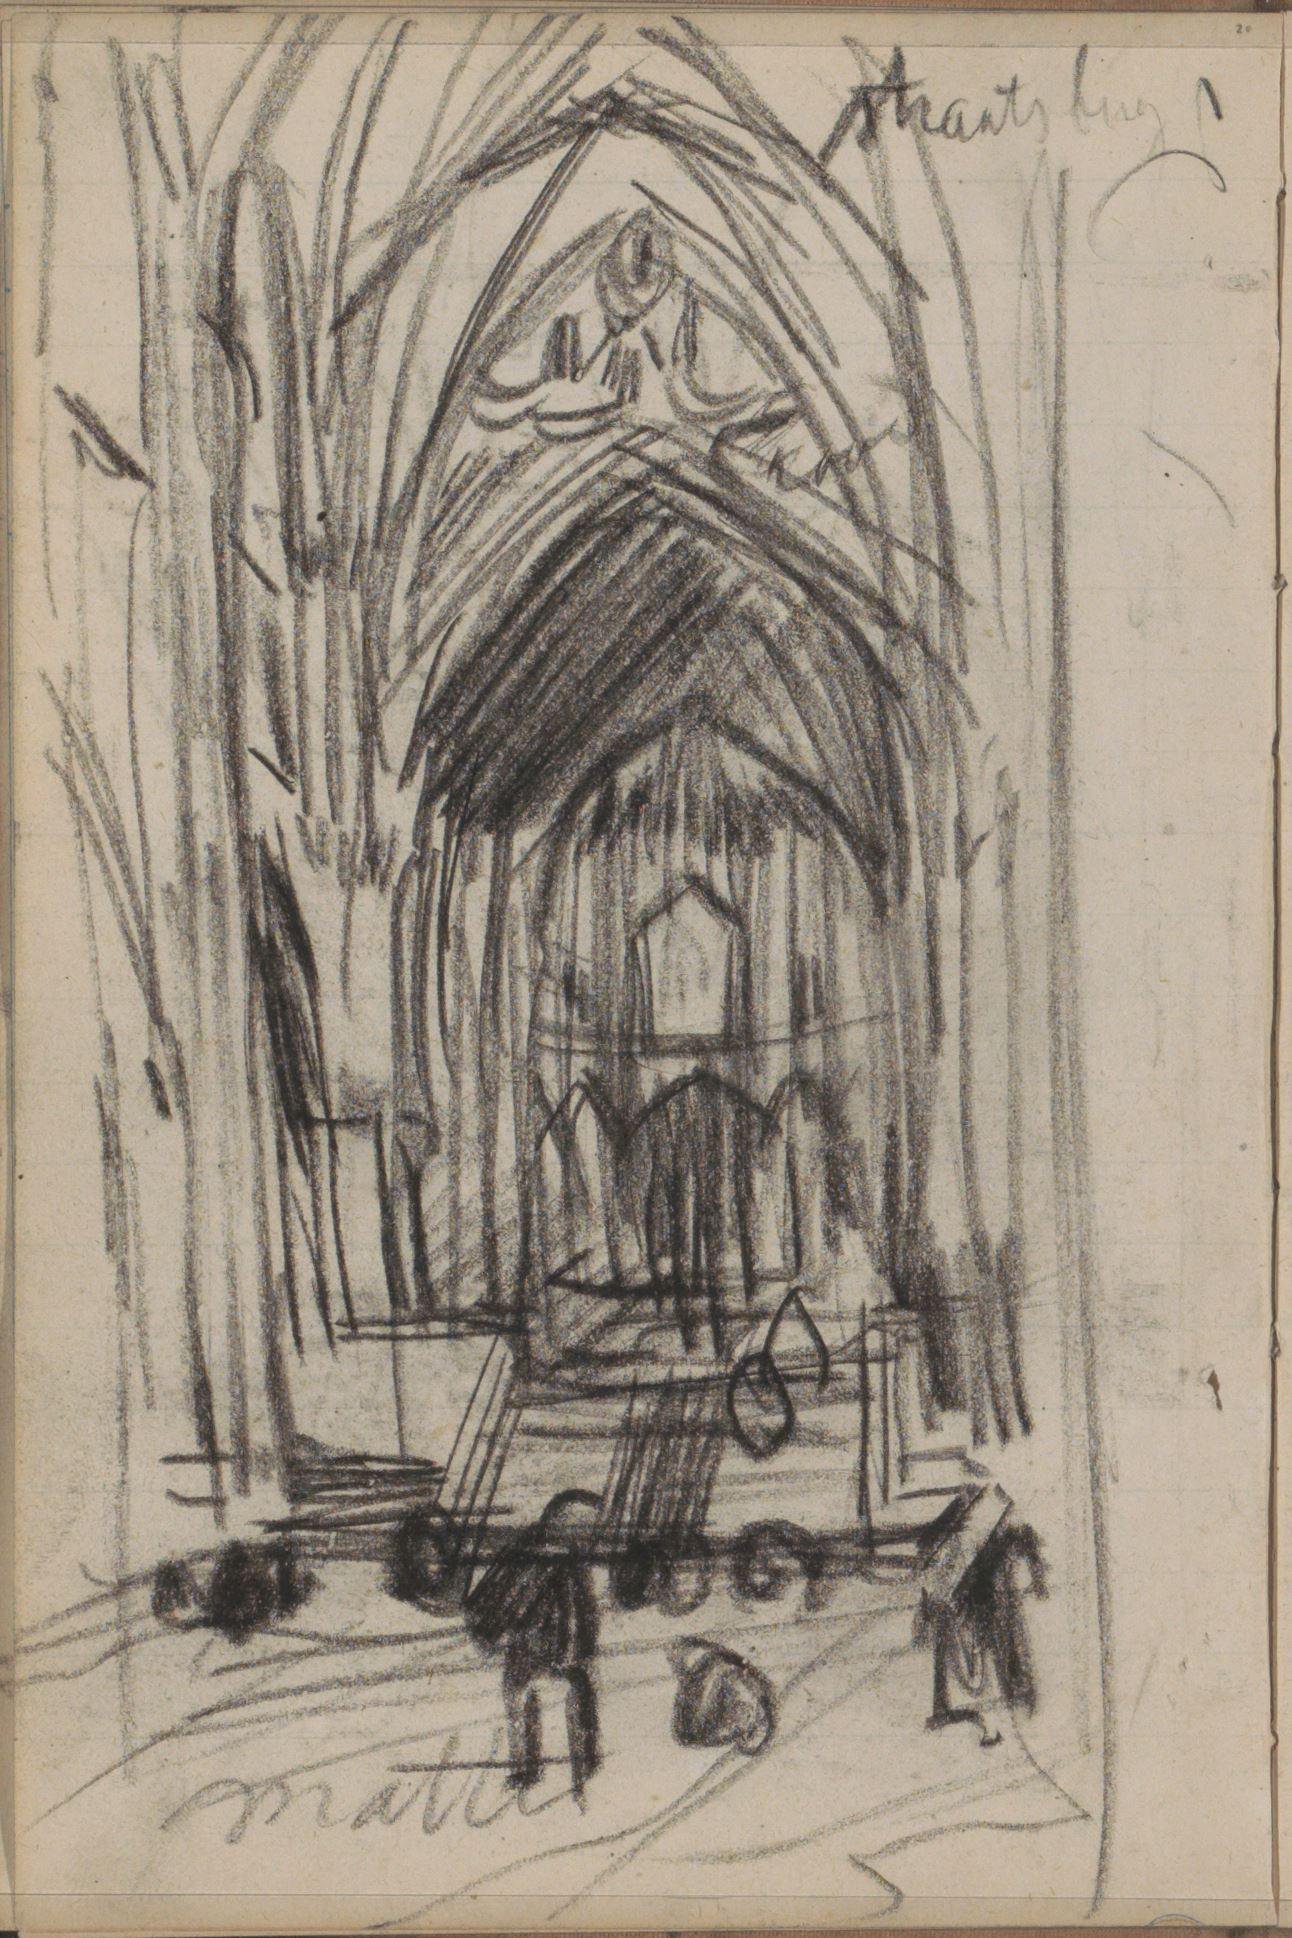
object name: sketchbook leaf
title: Interieur van de kathedraal van Straatsburg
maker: marius bauer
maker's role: draughtsman, print maker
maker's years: 1867-1932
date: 1888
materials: chalk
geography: straatsburg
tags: interior of church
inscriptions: annotation: ‘straatsburg’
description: Pagina 20 uit een schetsboek met 49 bladen.